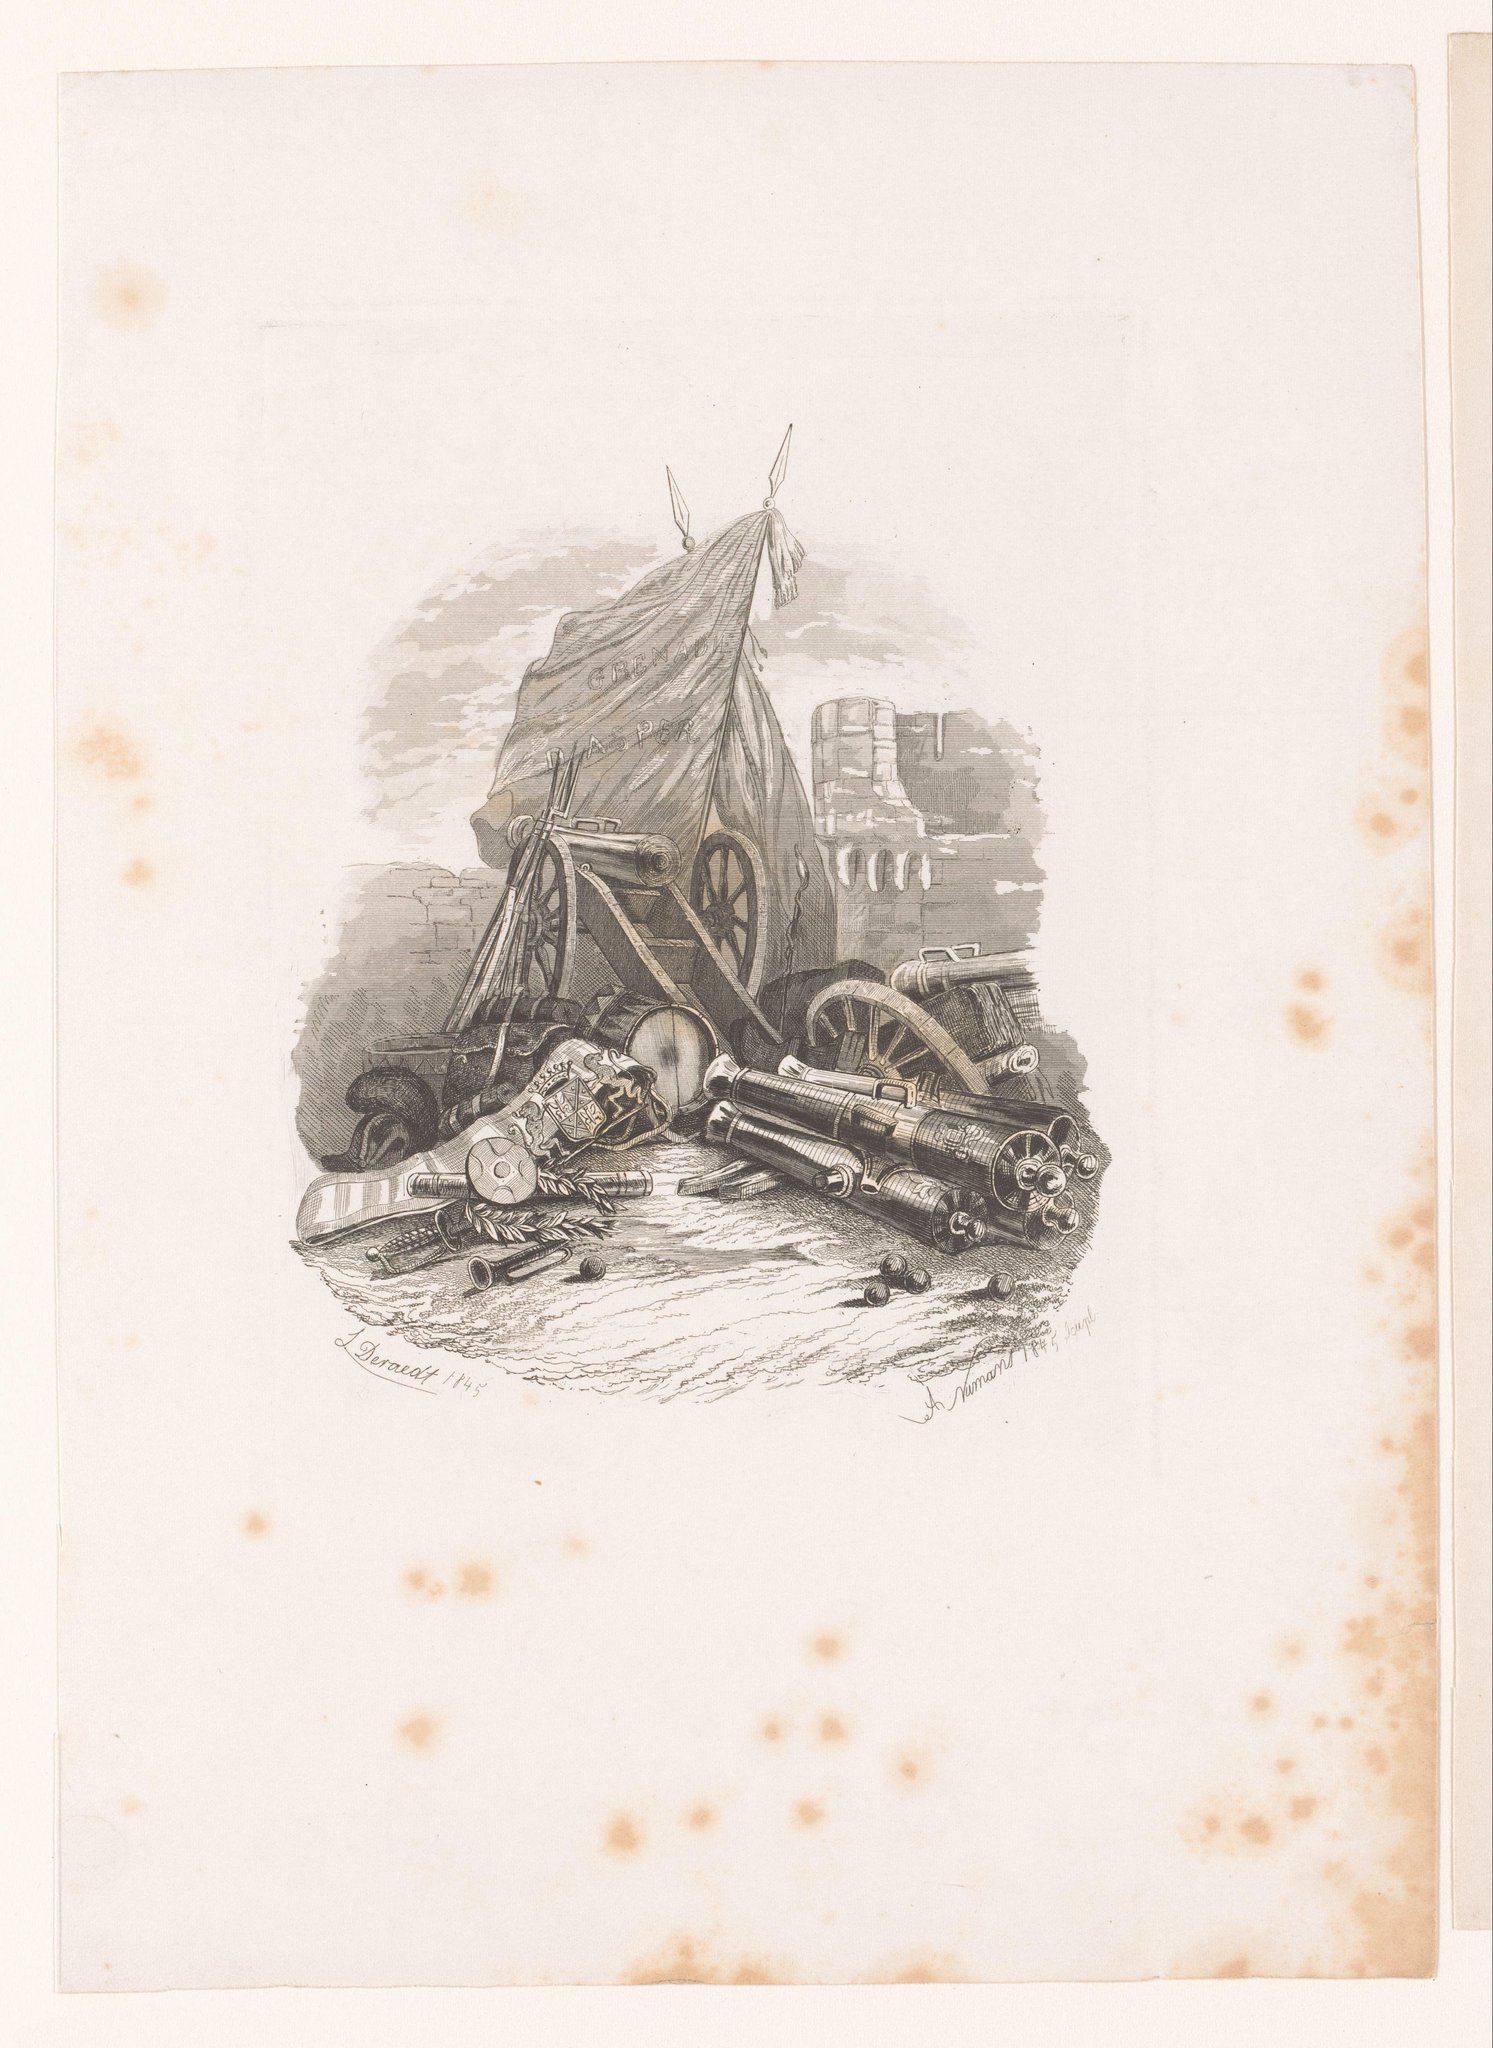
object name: print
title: Militaire trofeeën van de Grenadiers van Asper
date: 1845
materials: paper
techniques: etching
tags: trophy ~ battle, war, firearms: cannon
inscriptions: collector's mark: Lugt 2228